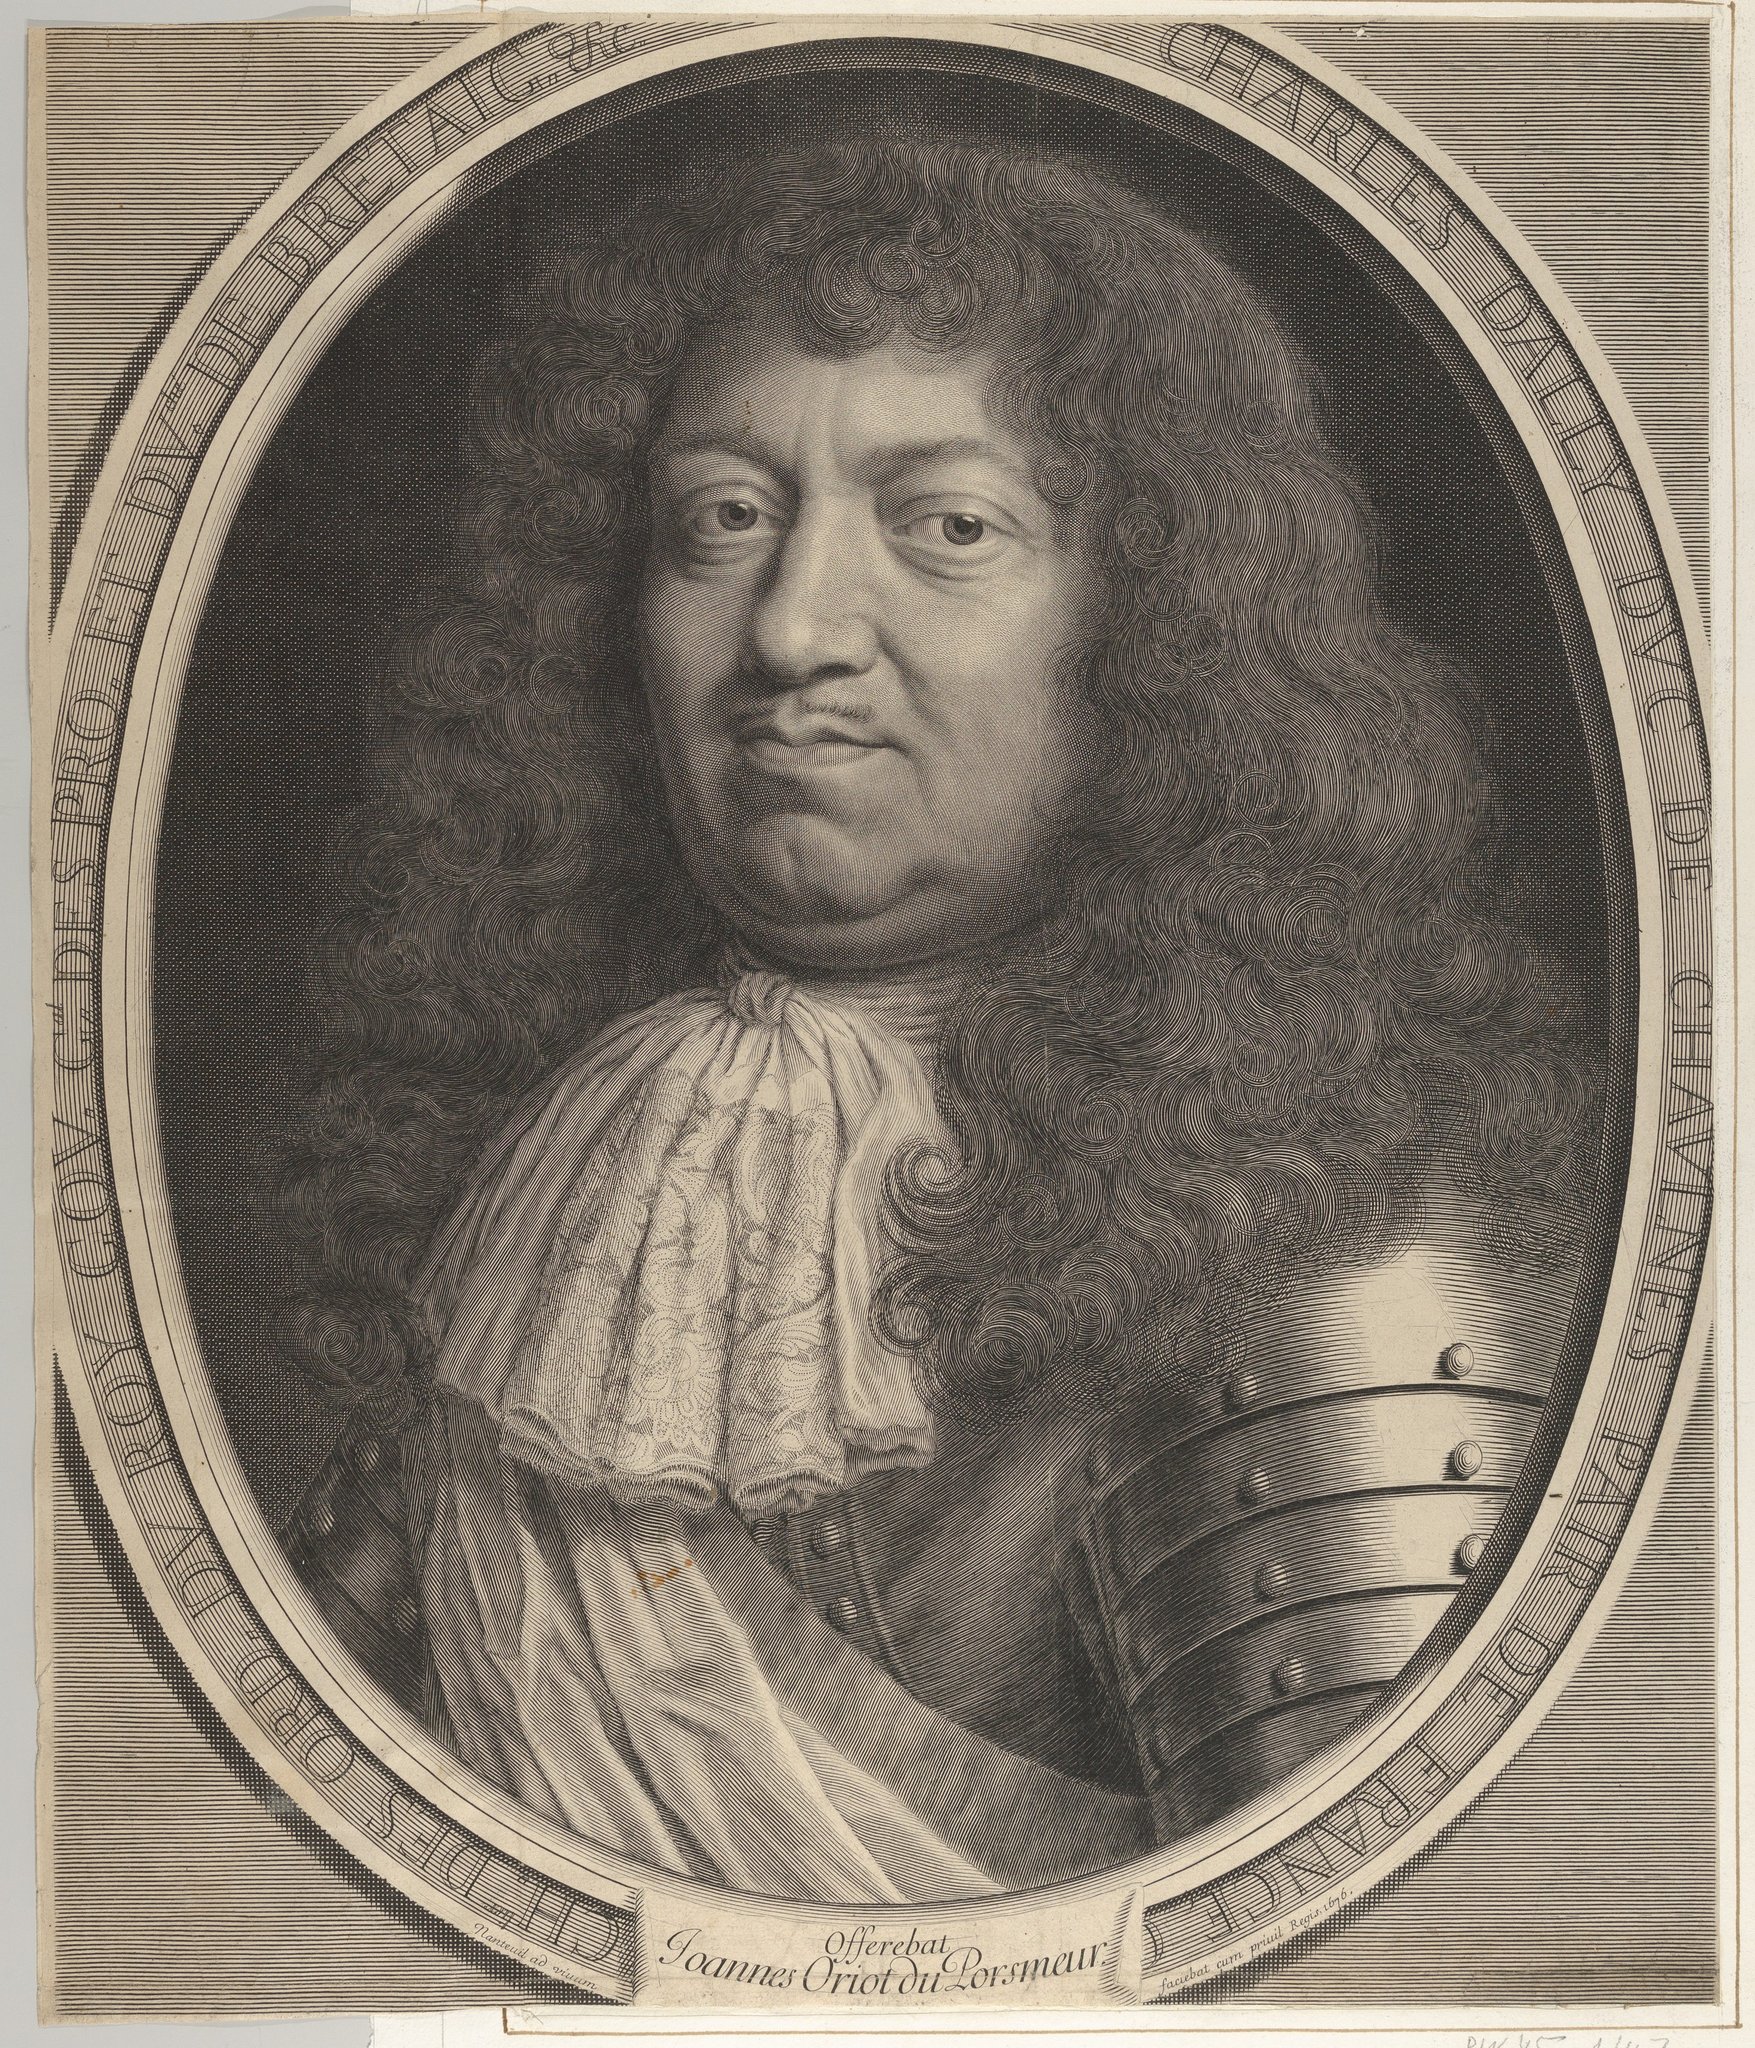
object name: print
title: Charles d'Albert d'Ailly, duc de Chaulnes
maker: robert nanteuil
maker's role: artist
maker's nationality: french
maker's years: 1623-1678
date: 1676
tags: men,portraits